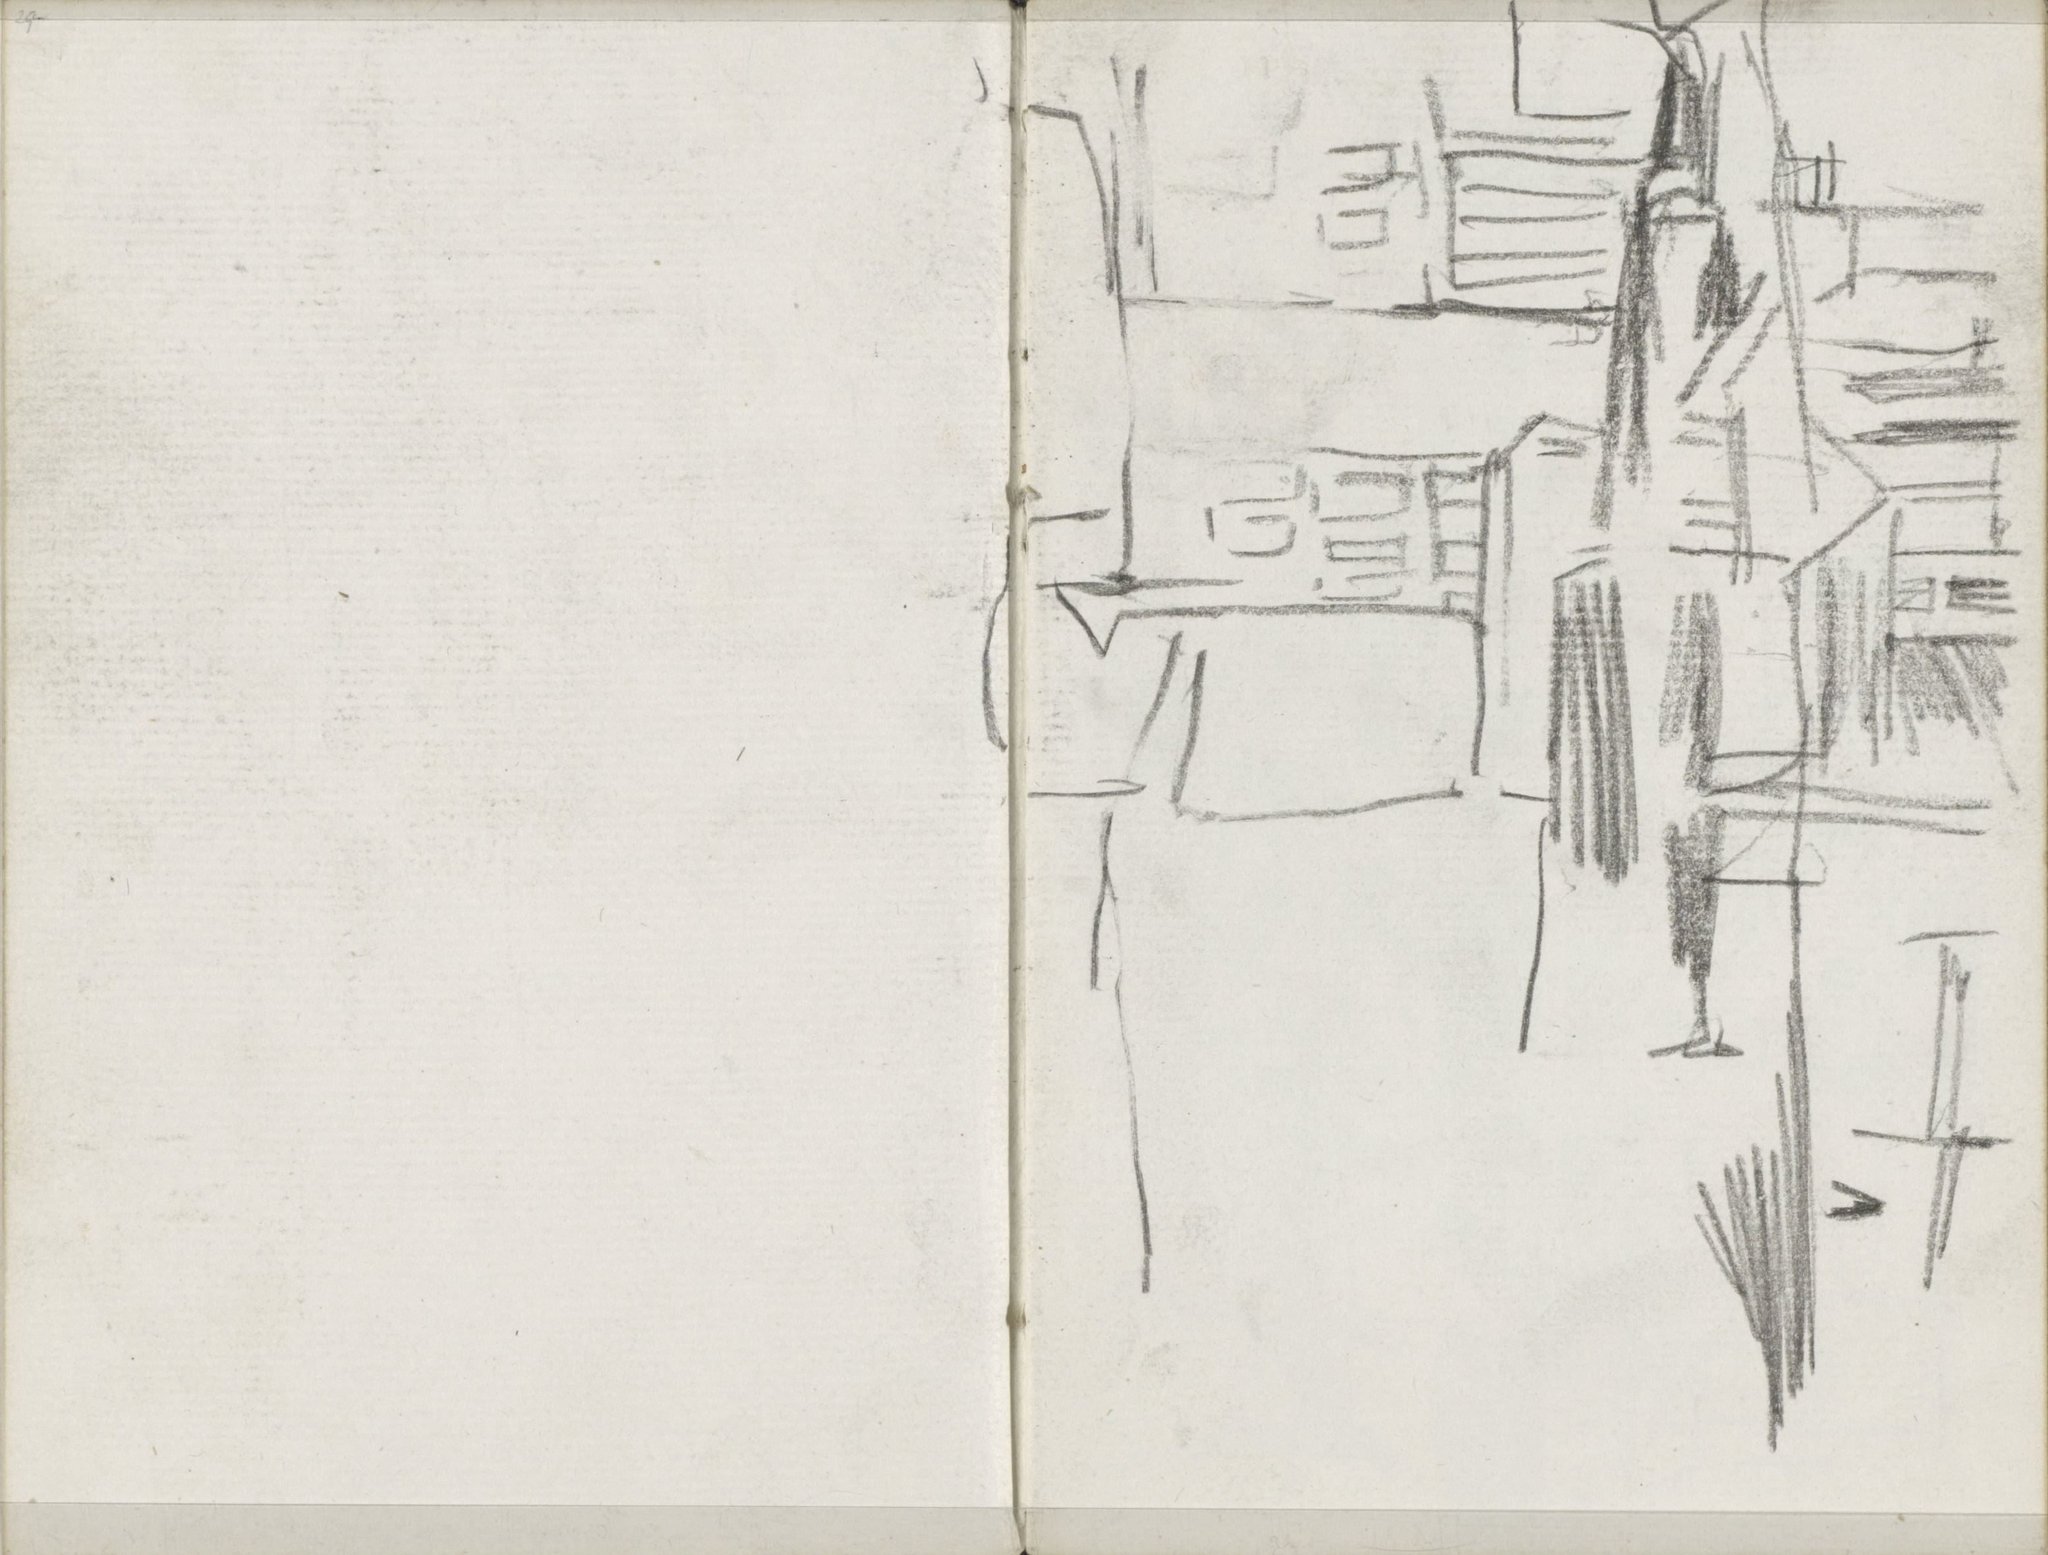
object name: sketchbook leaf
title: Gezicht op gebouwen, mogelijk te Amsterdam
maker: george hendrik breitner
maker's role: draughtsman, painter, print maker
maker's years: 1857-1923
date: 1886-1895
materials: chalk, paper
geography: amsterdam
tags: city-view, and landscape with man-made constructions, civic architecture; edifices; dwellings, amsterdam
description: Pagina 29 en pagina 30 uit een schetsboek met 20 bladen.